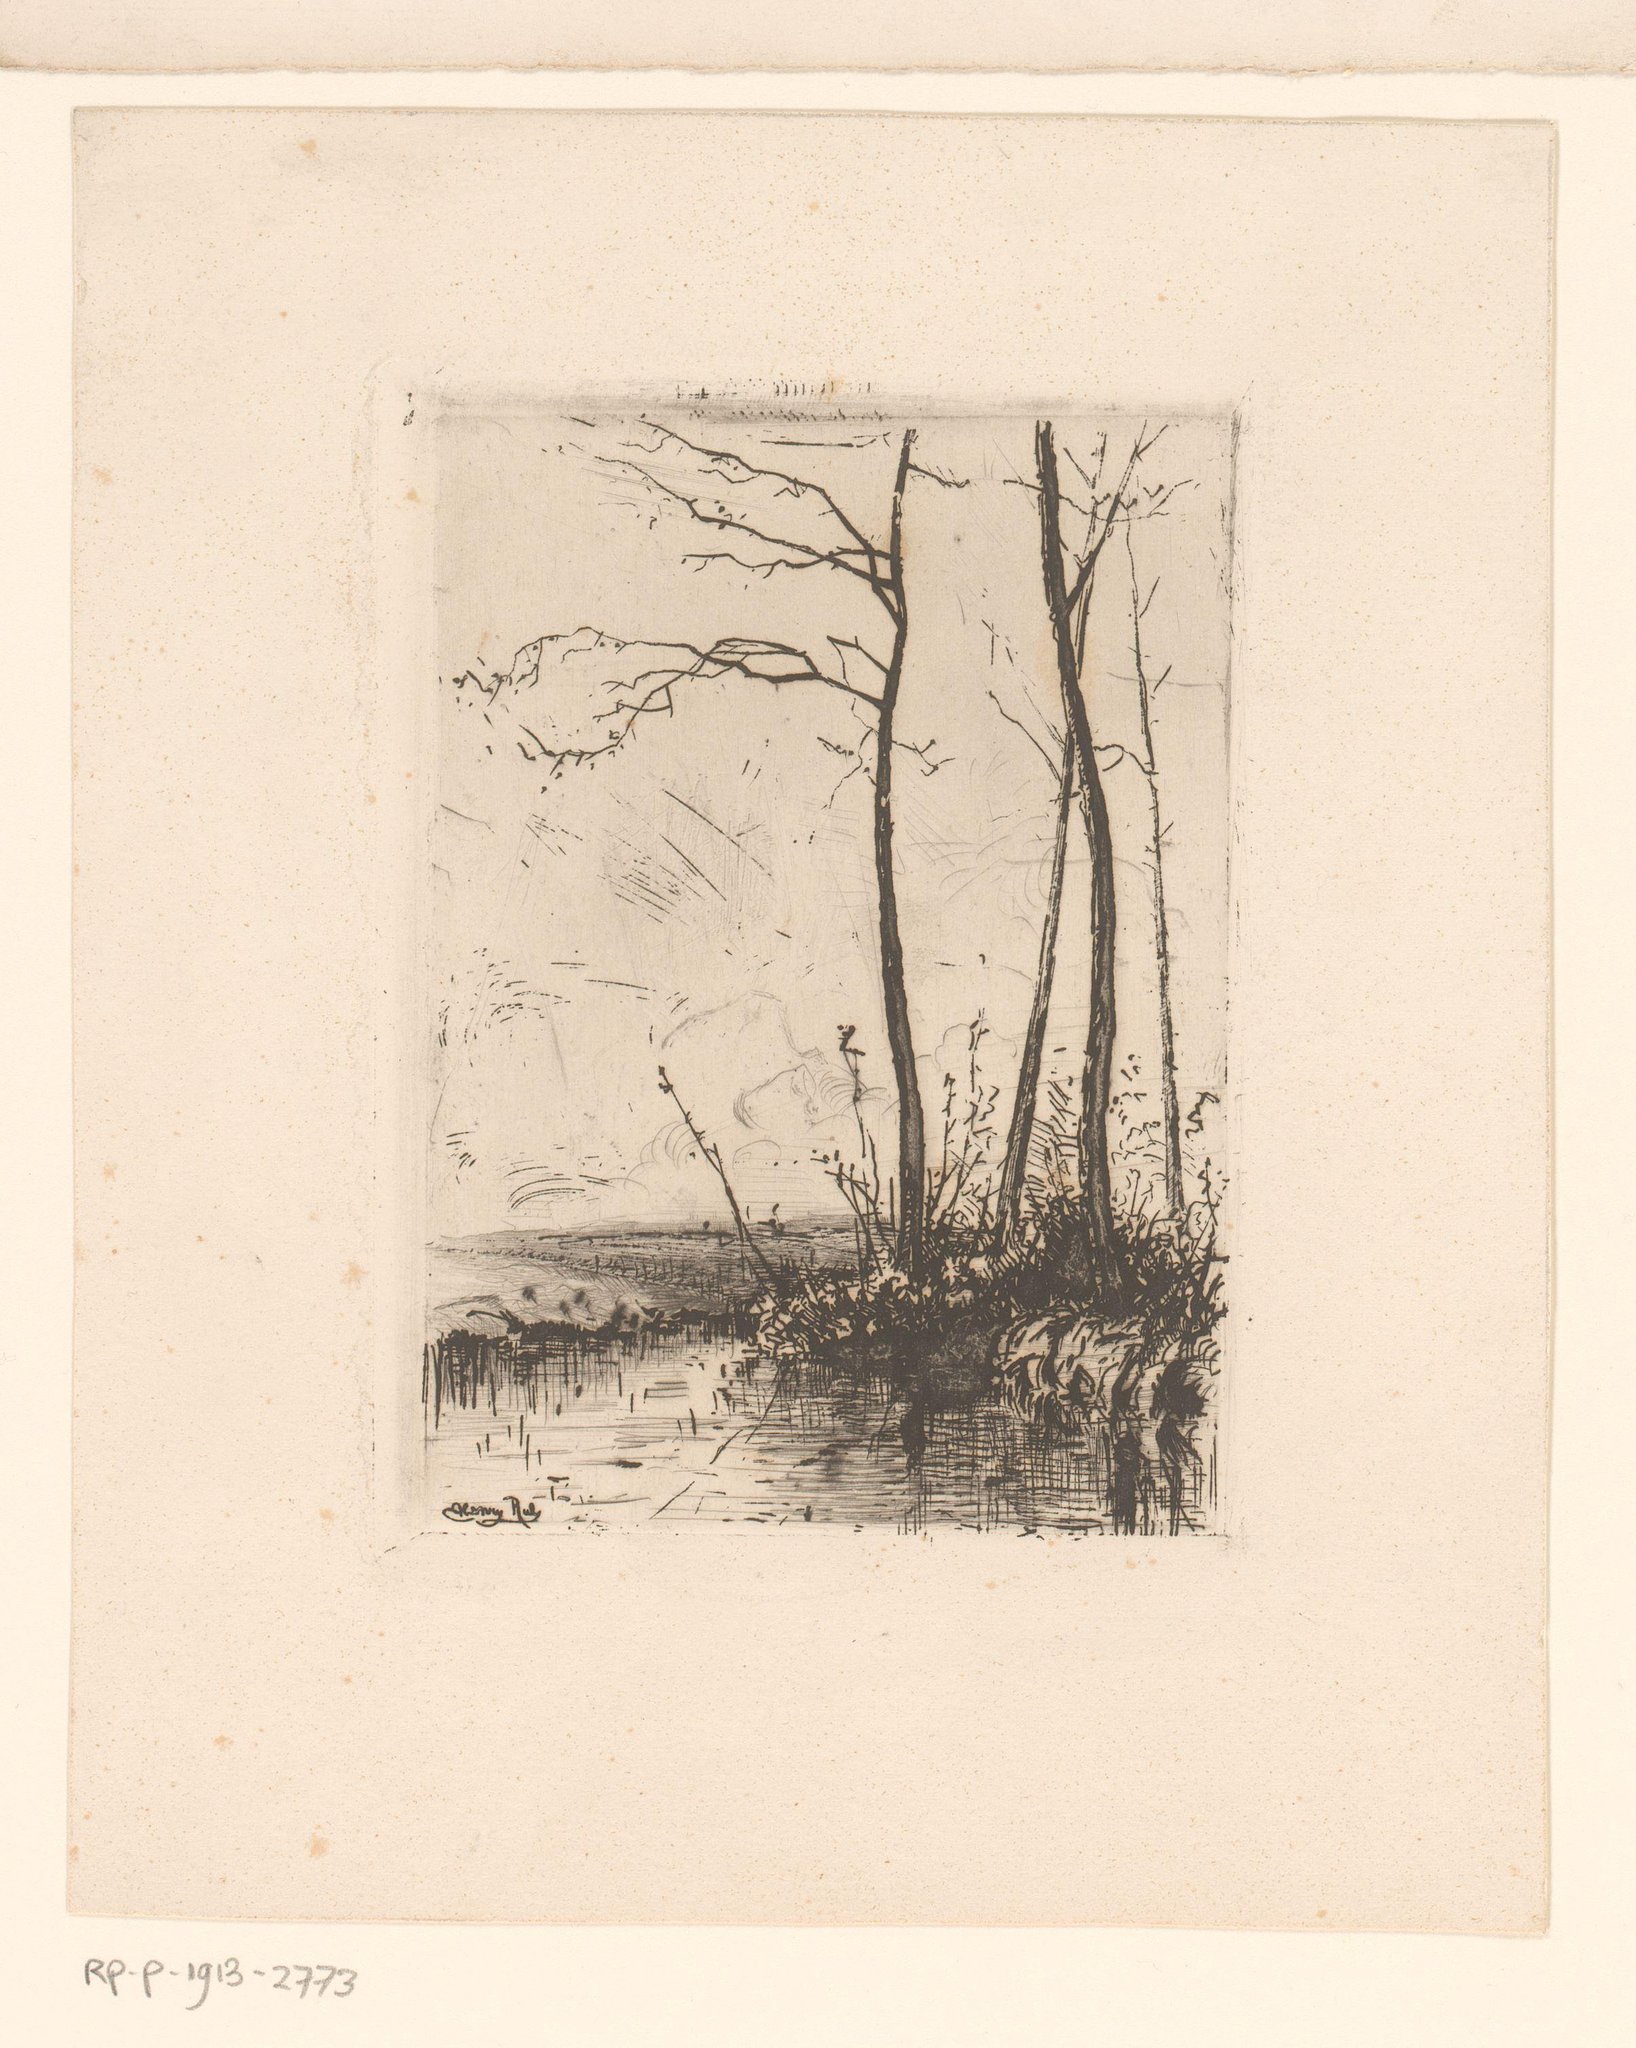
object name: print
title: Landschap met kale bomen aan een sloot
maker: henri rul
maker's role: print maker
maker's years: 1862-1942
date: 1872-1913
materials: paper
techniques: drypoint, etching, intaglio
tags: brook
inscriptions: collector's mark: Lugt 2228